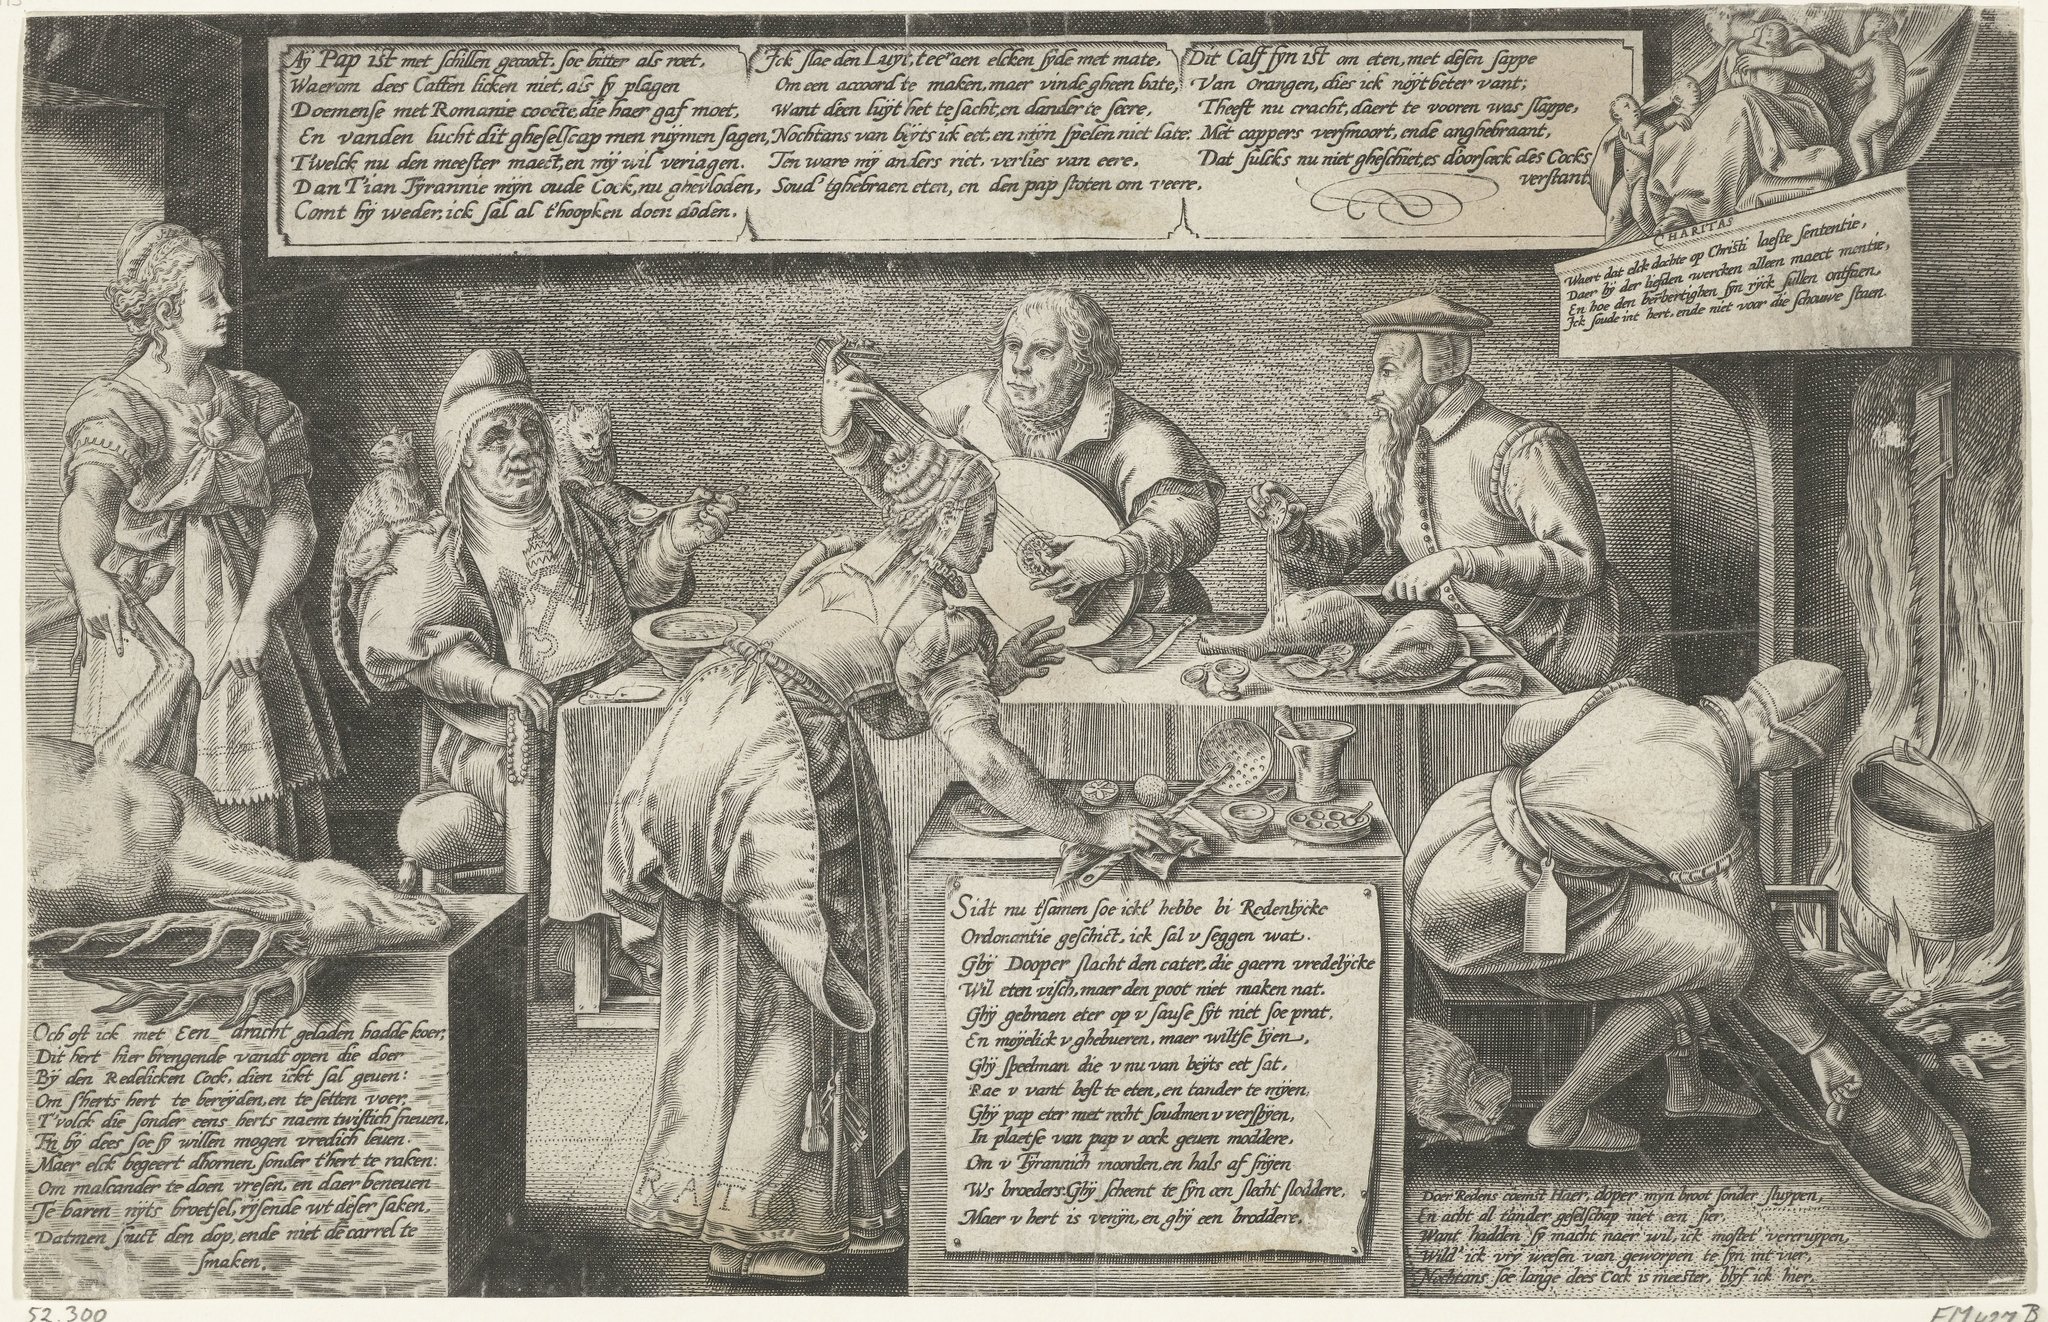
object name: print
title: De Rede maant de kerken tot verdraagzaamheid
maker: Anonymous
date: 1560-1599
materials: paper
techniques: engraving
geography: netherlands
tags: amsterdam, gouda, print maker, draughtsman, dirck volckertsz. coornhert, martin luther, reformation (roman catholic church vs. protestantism), rationality, reasoning; 'ratiocinatione o discorso' (ripa), evening meal, dinner, supper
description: De Rede maant de kerken tot verdraagzaamheid. Aan een tafel zitten de paus, Luther en Calvijn. Twee katten zitten op de schouders van de paus die pap eet, Luther speel op de luit en Calvijn knijpt sinaasappelsap op zijn kalfsvlees. Rechts knielt een doper bij de haard. Boven de haard een beeldengroep van Charitas. Op de voorgrond staat een personificatie van de Rede (Ratio) in de figuur van een keukenmeid, links bij de deur een andere keukenmeid die waarschijnlijk Verdraagzaamheid personifieert met een hert (een verwijzing naar Coornhert?). Allegorie op de hervorming, ca. 1560. In de voorstelling meerdere cartouches met teksten in het Nederlands. Misschien het origineel of anders een vroege kopie naar een onbekend origineel.